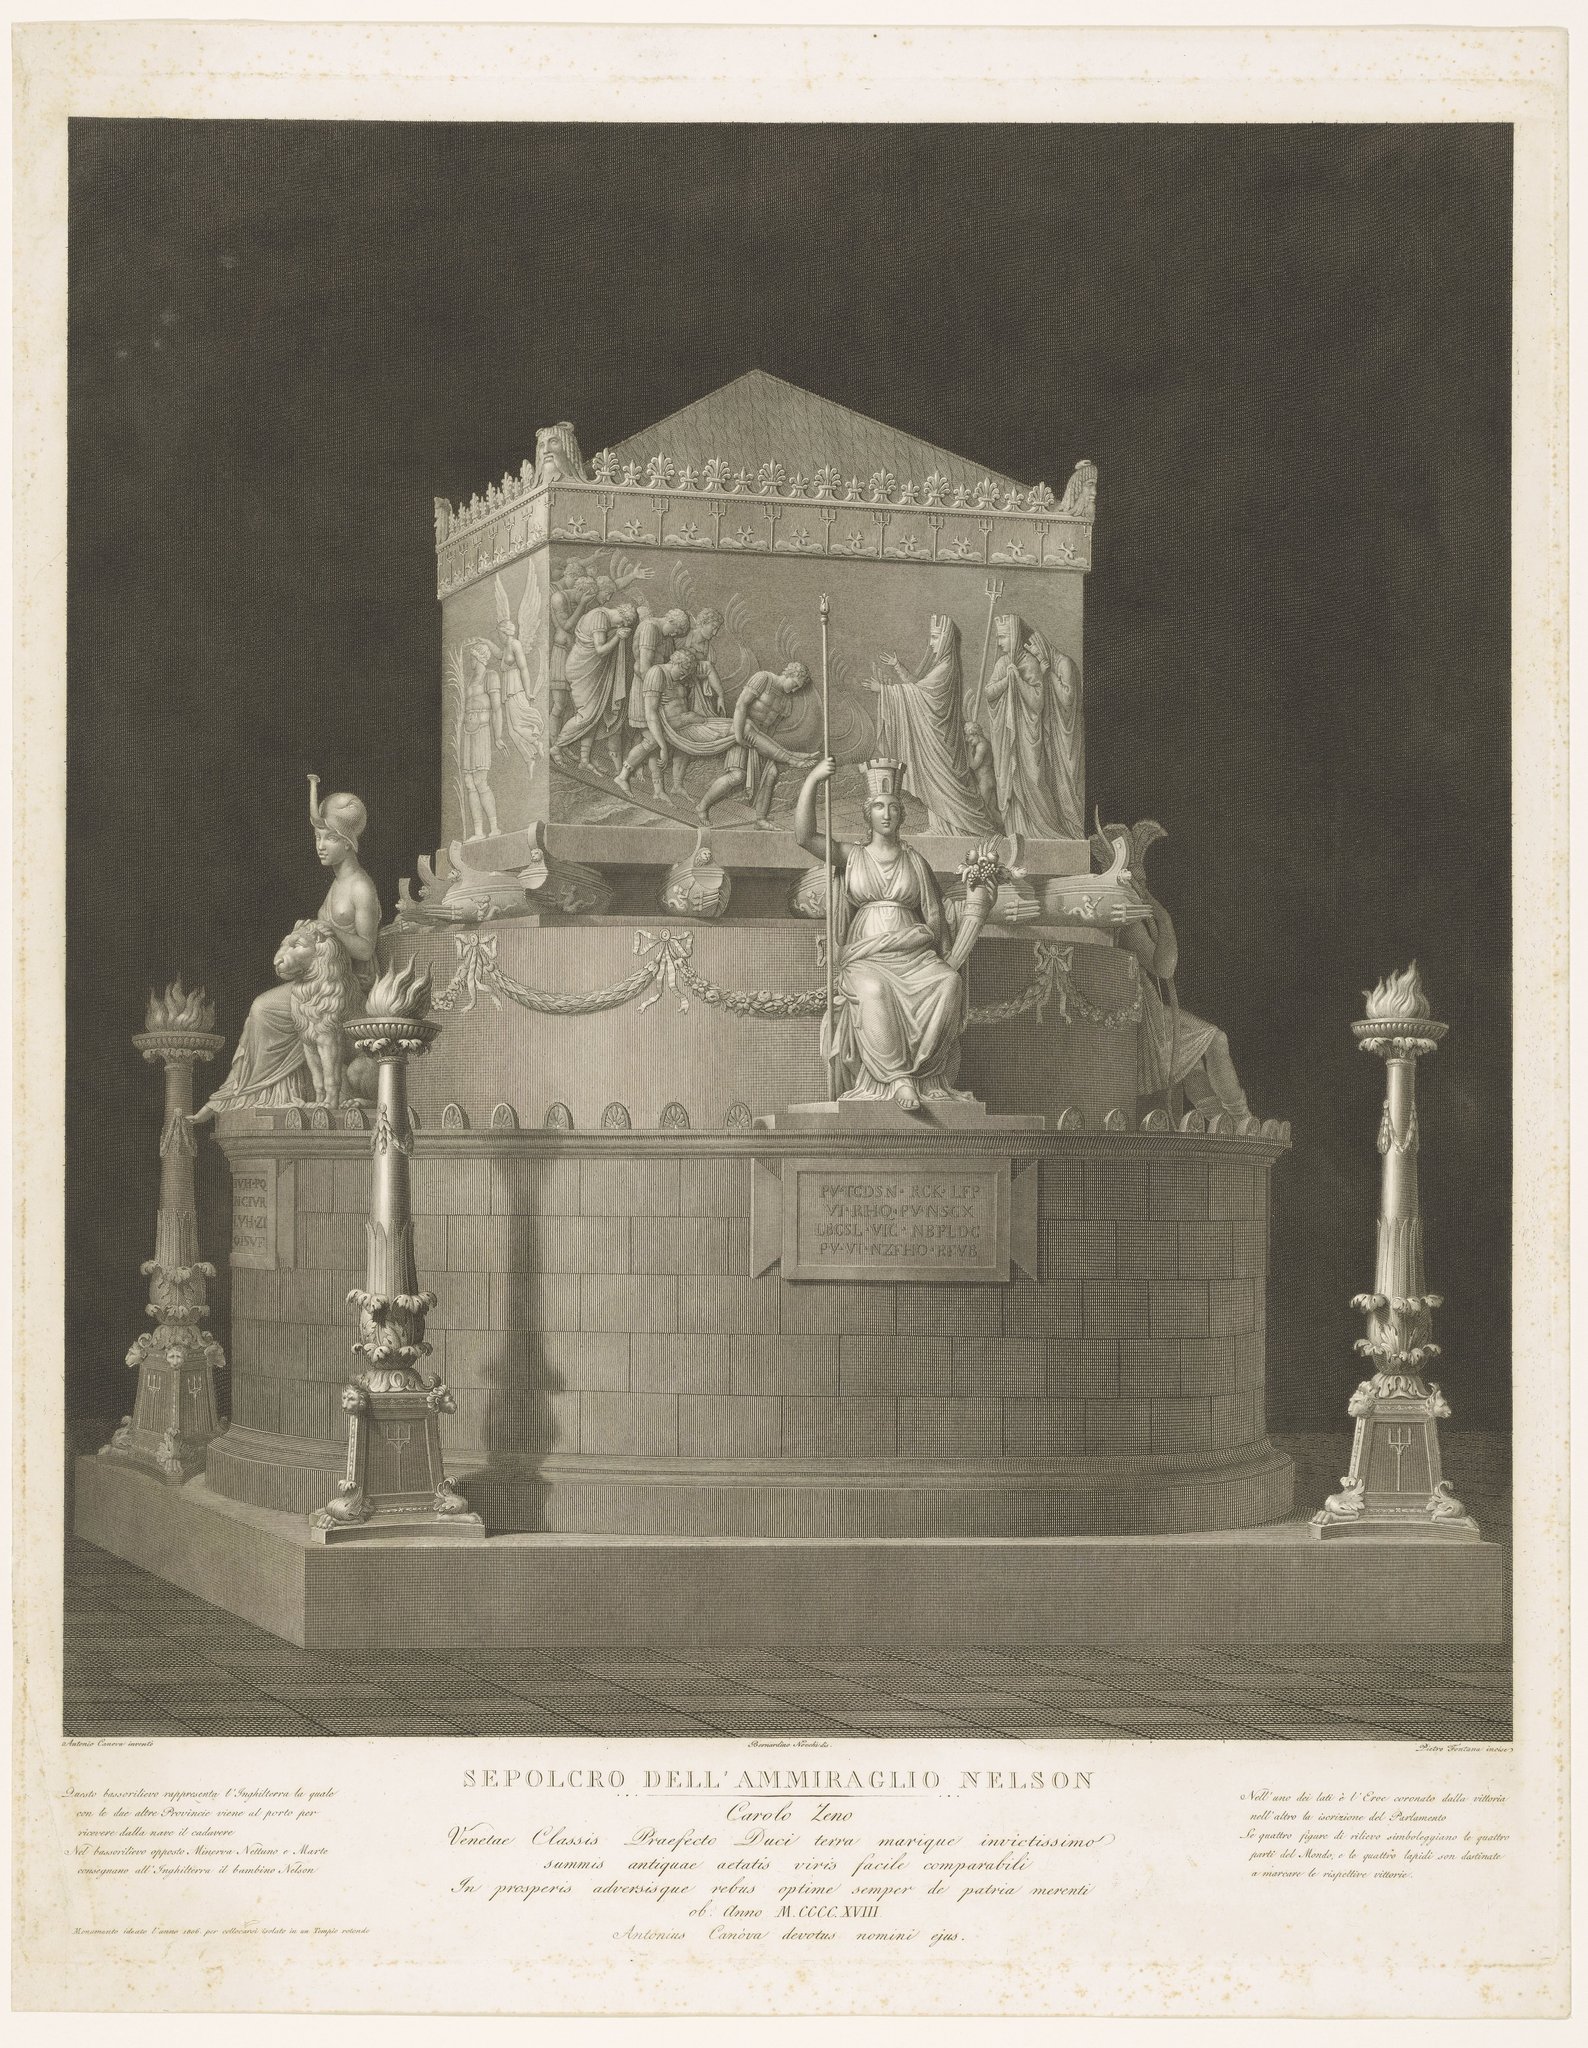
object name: print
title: Sepolcro dell'ammiraglio Nelson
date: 1805-1837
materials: paper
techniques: engraving, etching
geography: italy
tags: horatio nelson (hertog van bronte), grave, tomb, monument, statue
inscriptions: collector's mark: Lugt 12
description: Het grafmonument voor Horatio Nelson door de Italiaanse beeldhouwer Antonio Canova. Tekst en opdracht in het Italiaans in ondermarge.